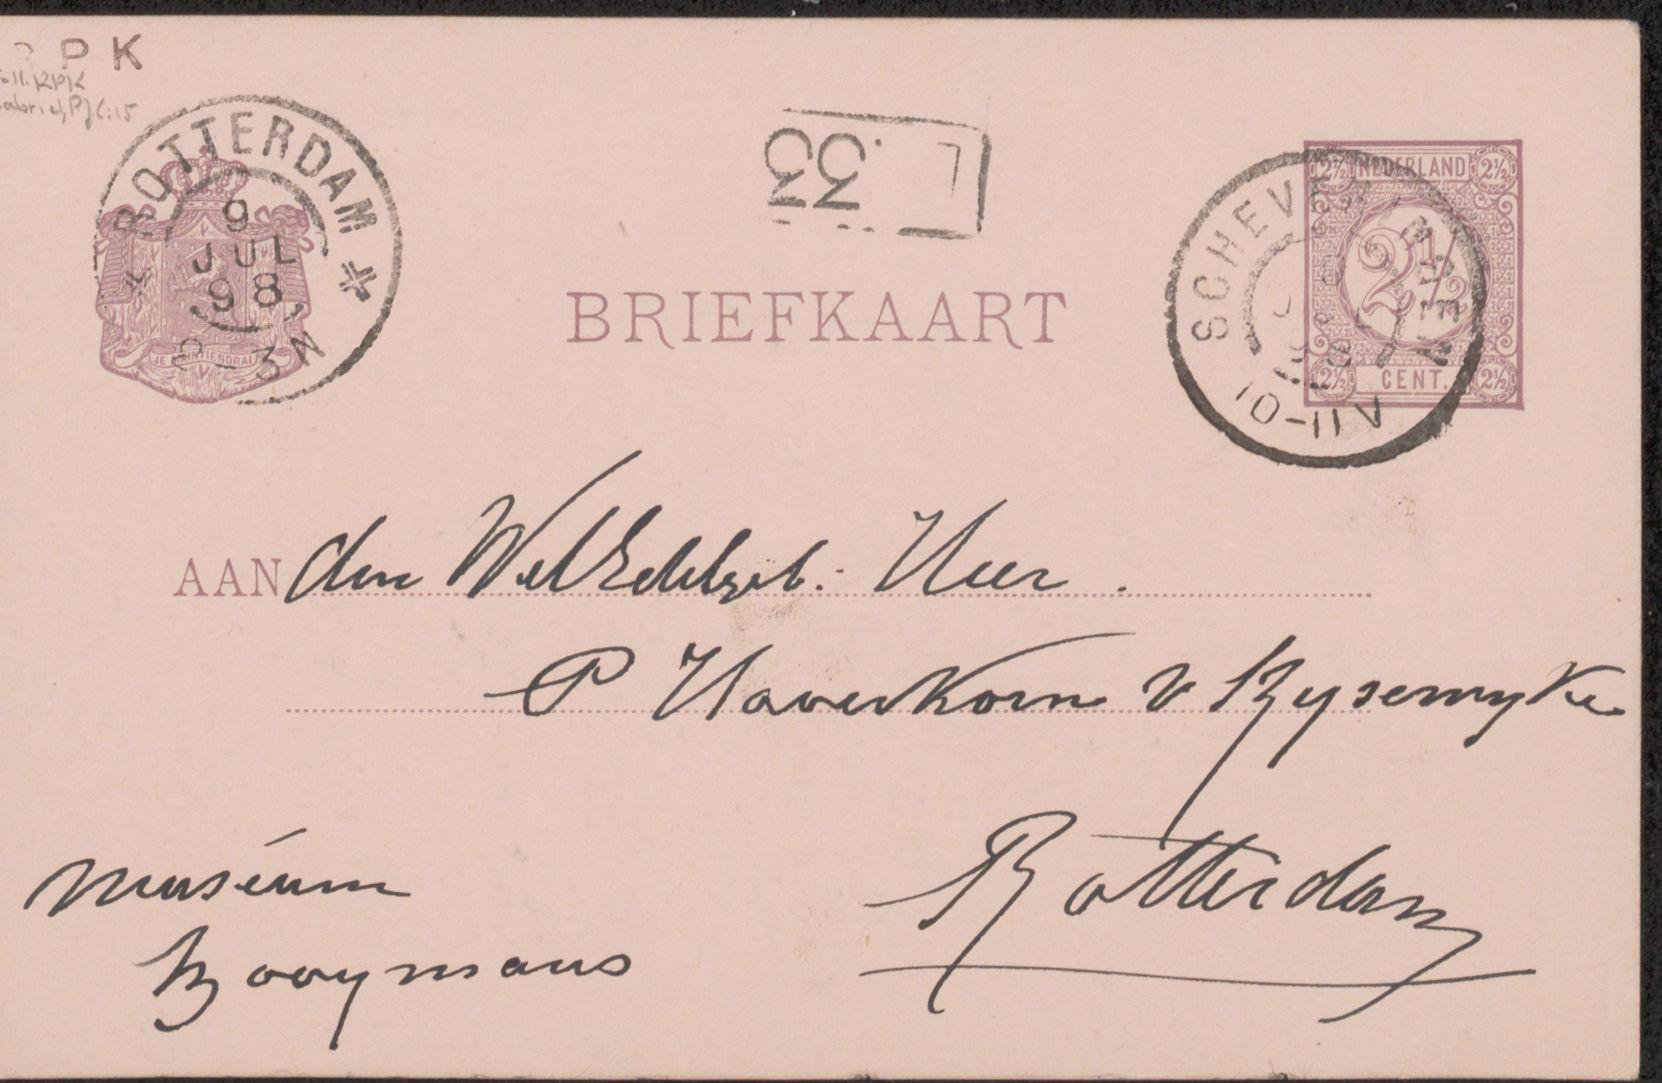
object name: postcard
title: Briefkaart aan Pieter Haverkorn van Rijsewijk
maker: paul joseph constantin gabriël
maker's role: draughtsman, print maker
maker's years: 1828-1903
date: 1898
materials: cardboard, ink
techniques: pen, writing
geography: scheveningen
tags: pieter haverkorn van rijsewijk, painting (including book-illumination, miniature-painting), workshop, studio of the artist (in general), exhibition ~ art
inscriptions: collector's mark: ‘RPK’